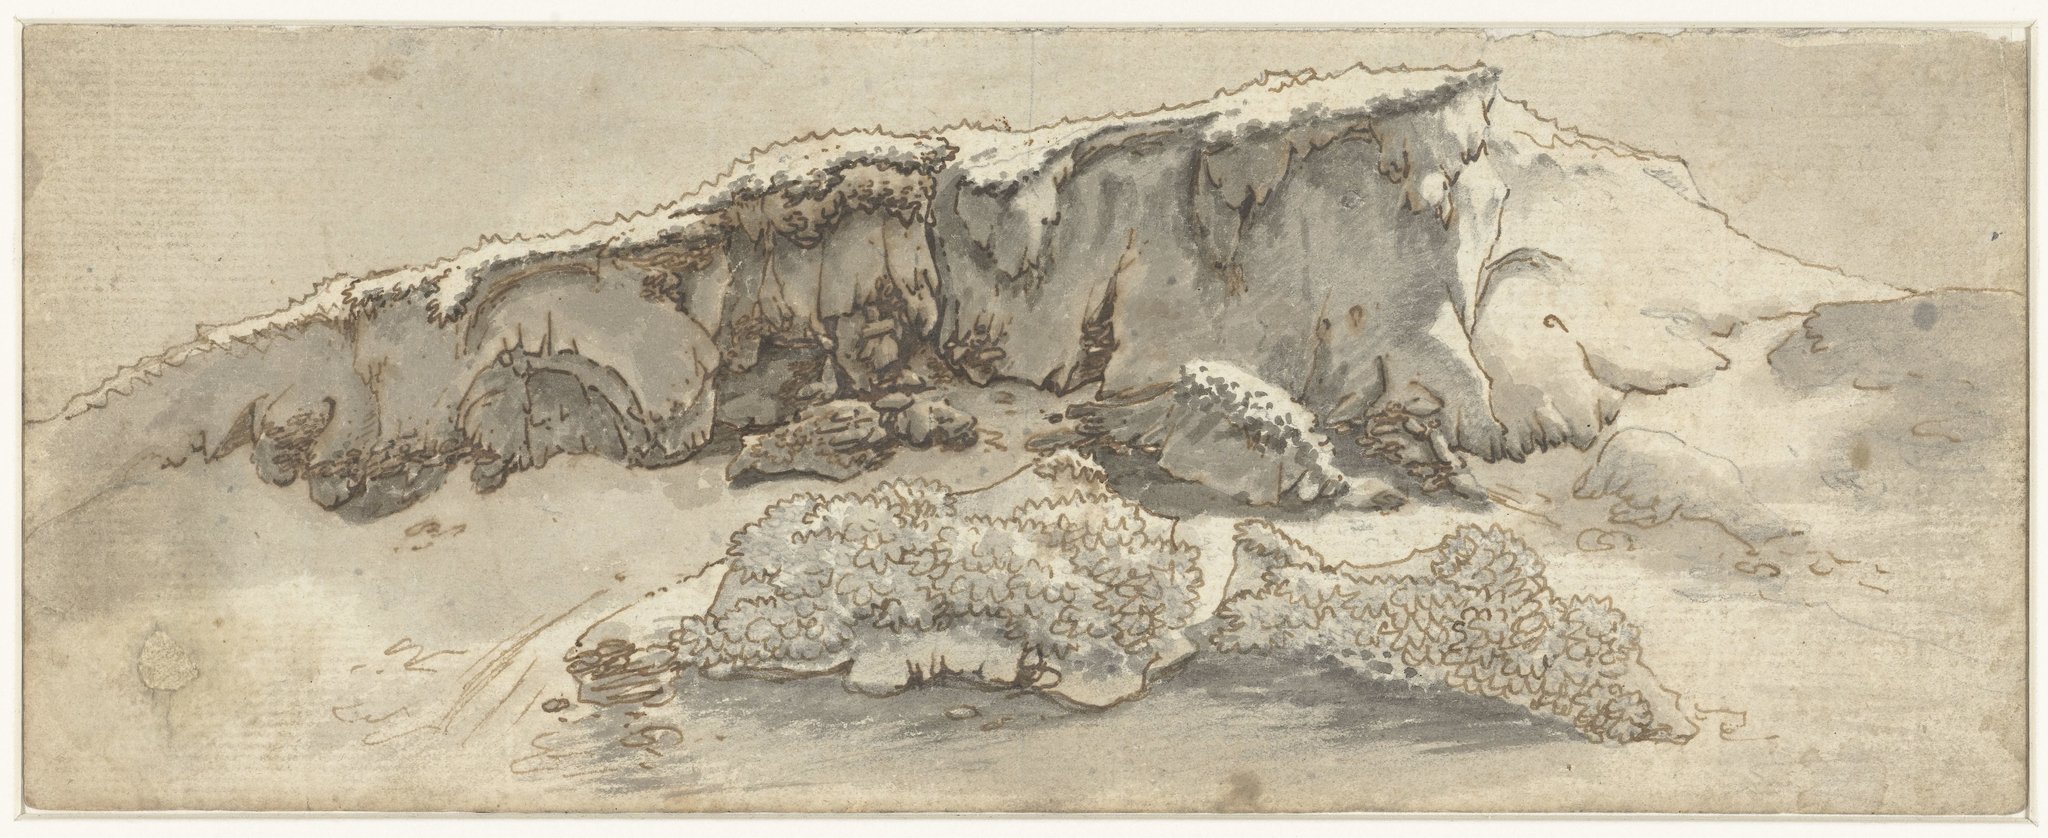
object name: drawing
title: Zandrug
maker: Anonymous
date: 1700-1800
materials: ink, paper, pencil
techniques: brush, pen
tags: dunes (sea not visible); in the dunes